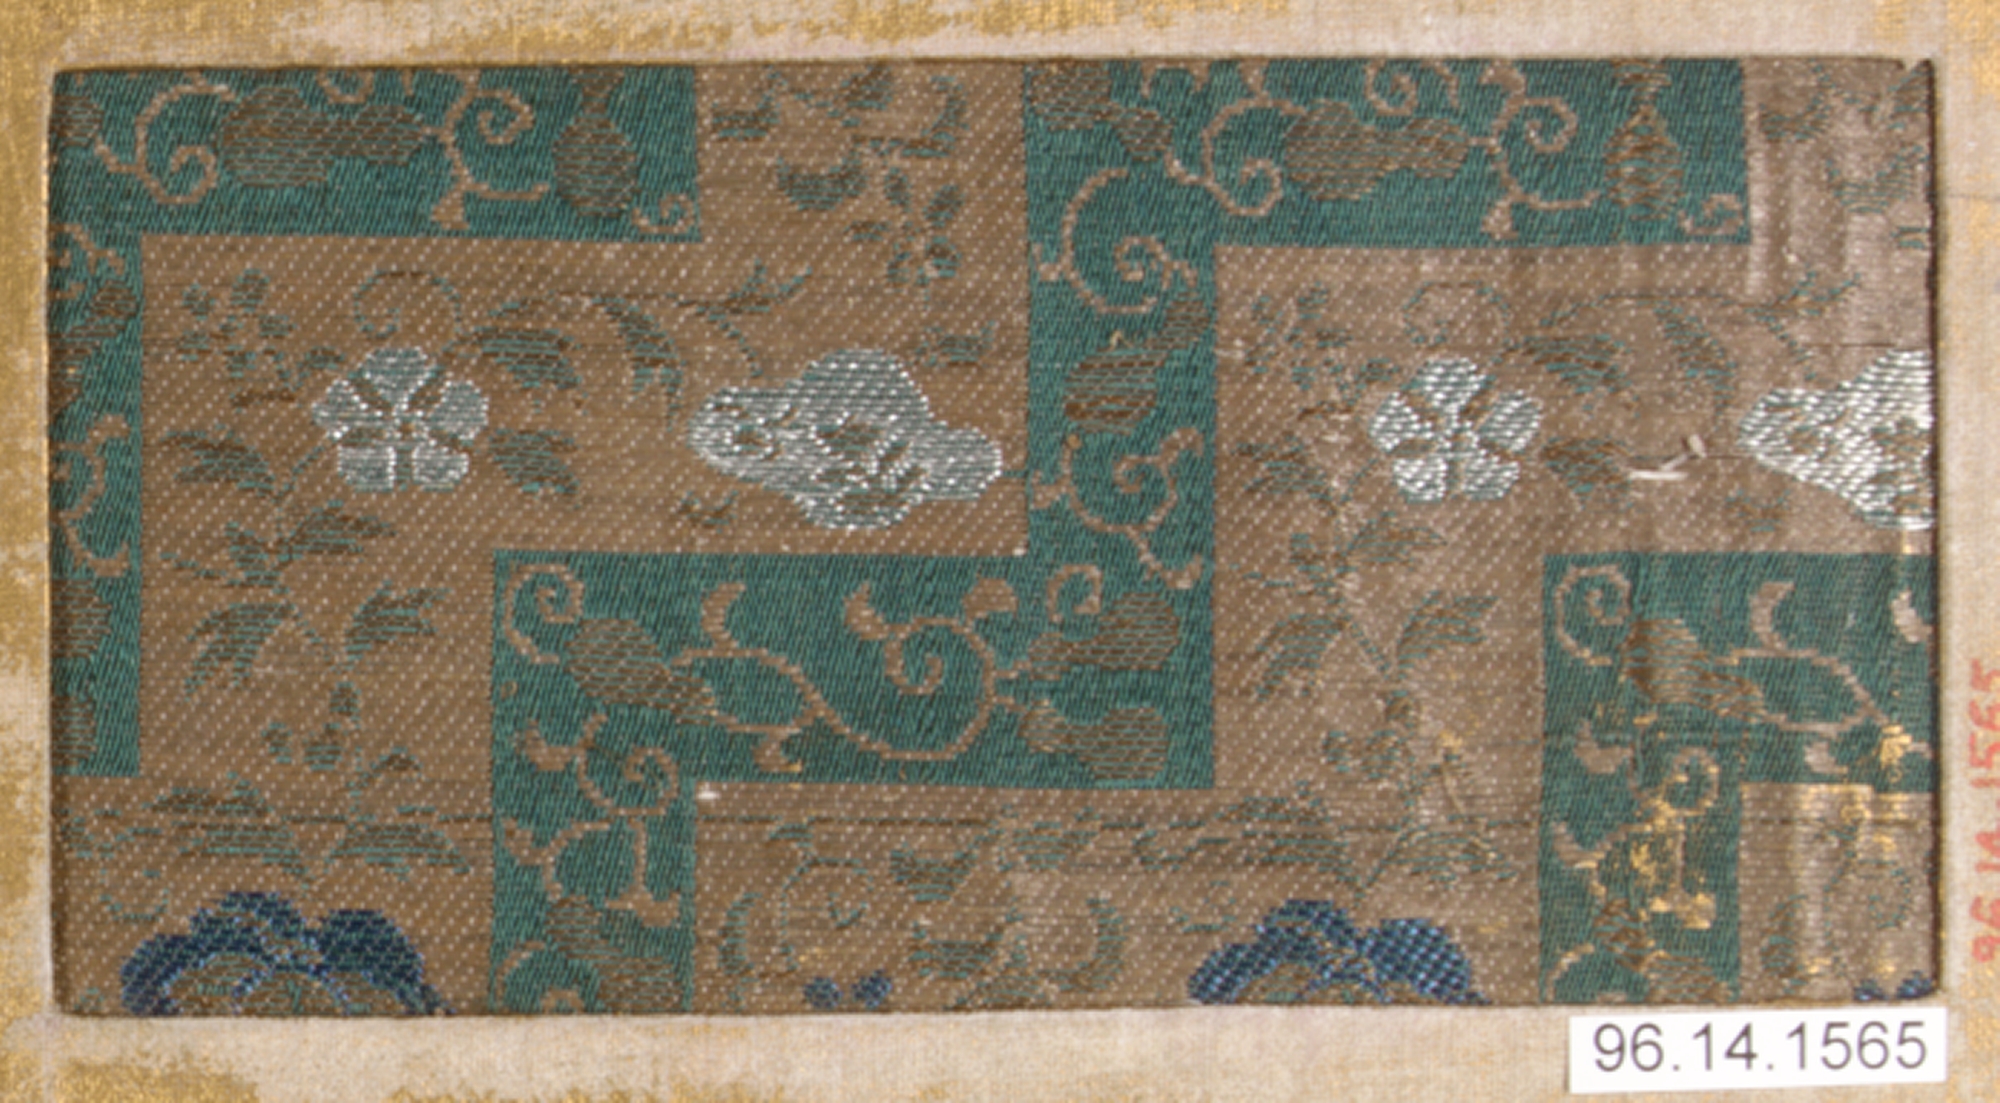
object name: piece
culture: japanese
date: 1701-1900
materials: silk